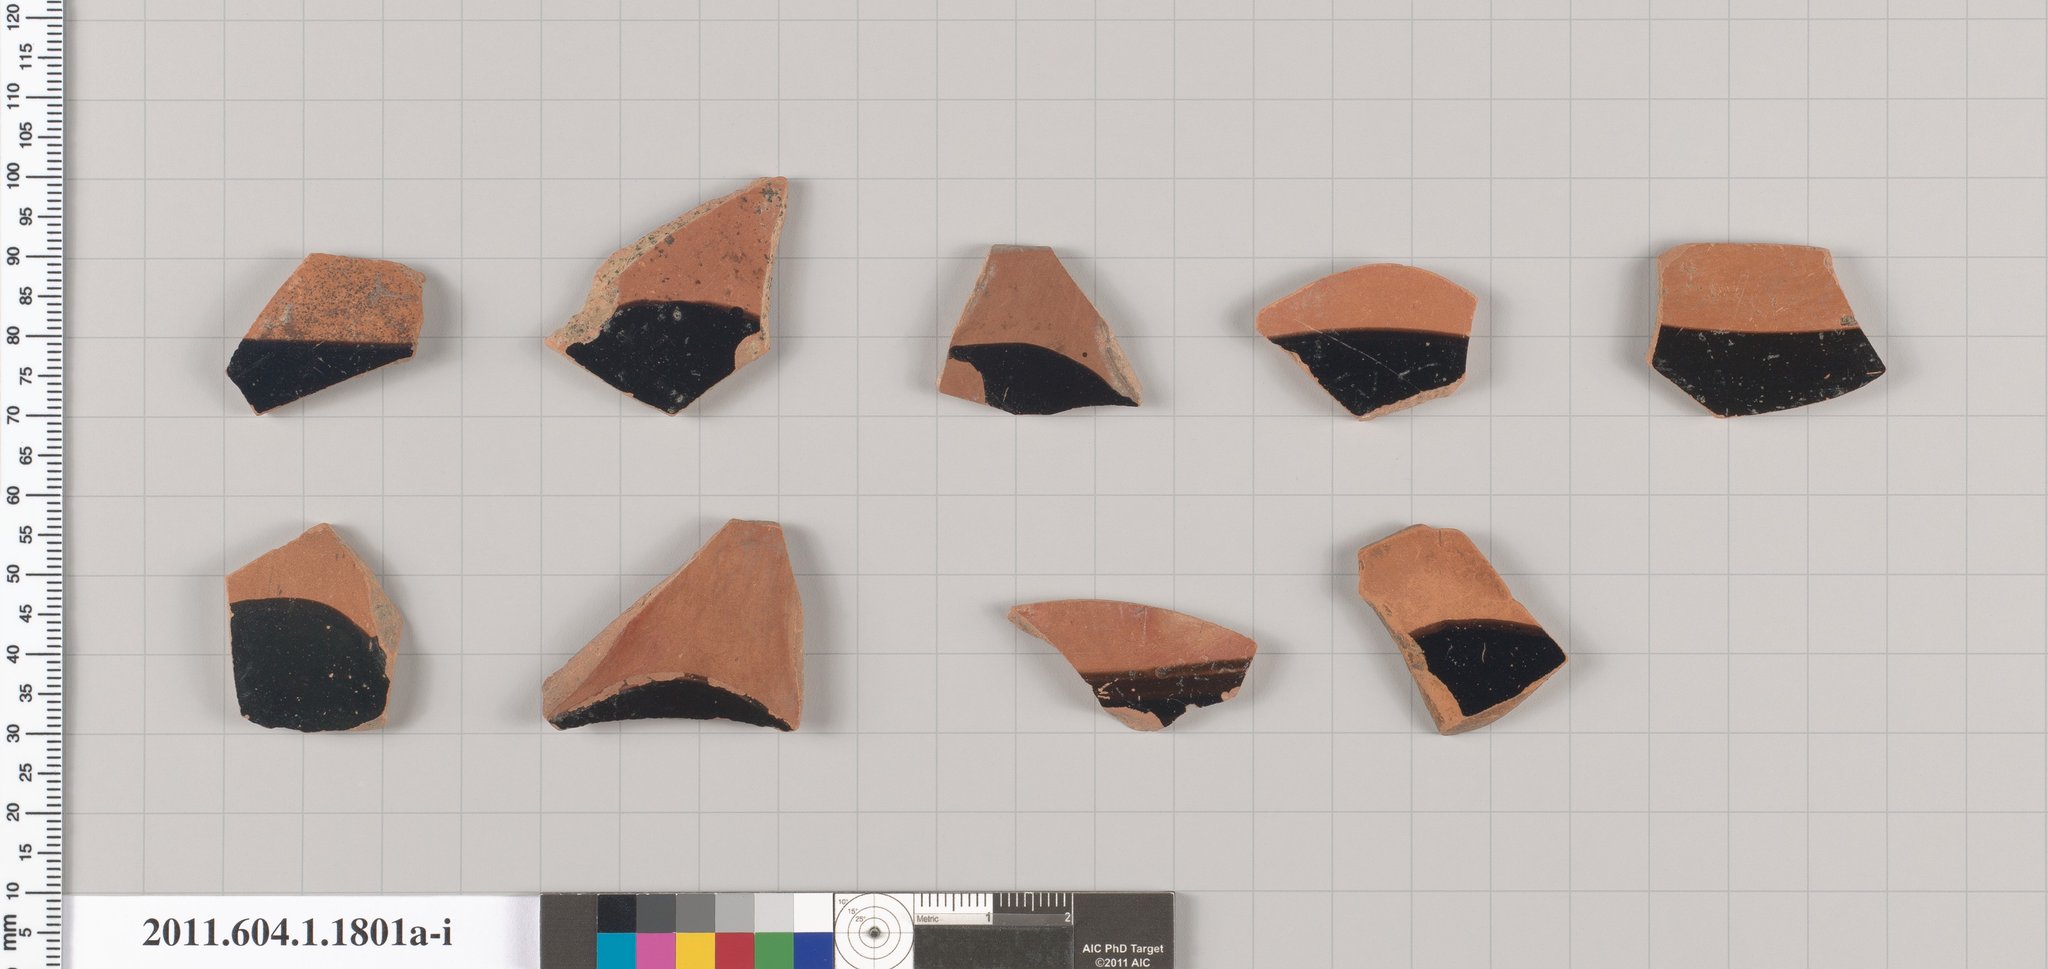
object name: kylix fragment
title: Terracotta rim fragments of kylikes(drinking cups)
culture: greek, attic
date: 500-401 BCE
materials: terracotta